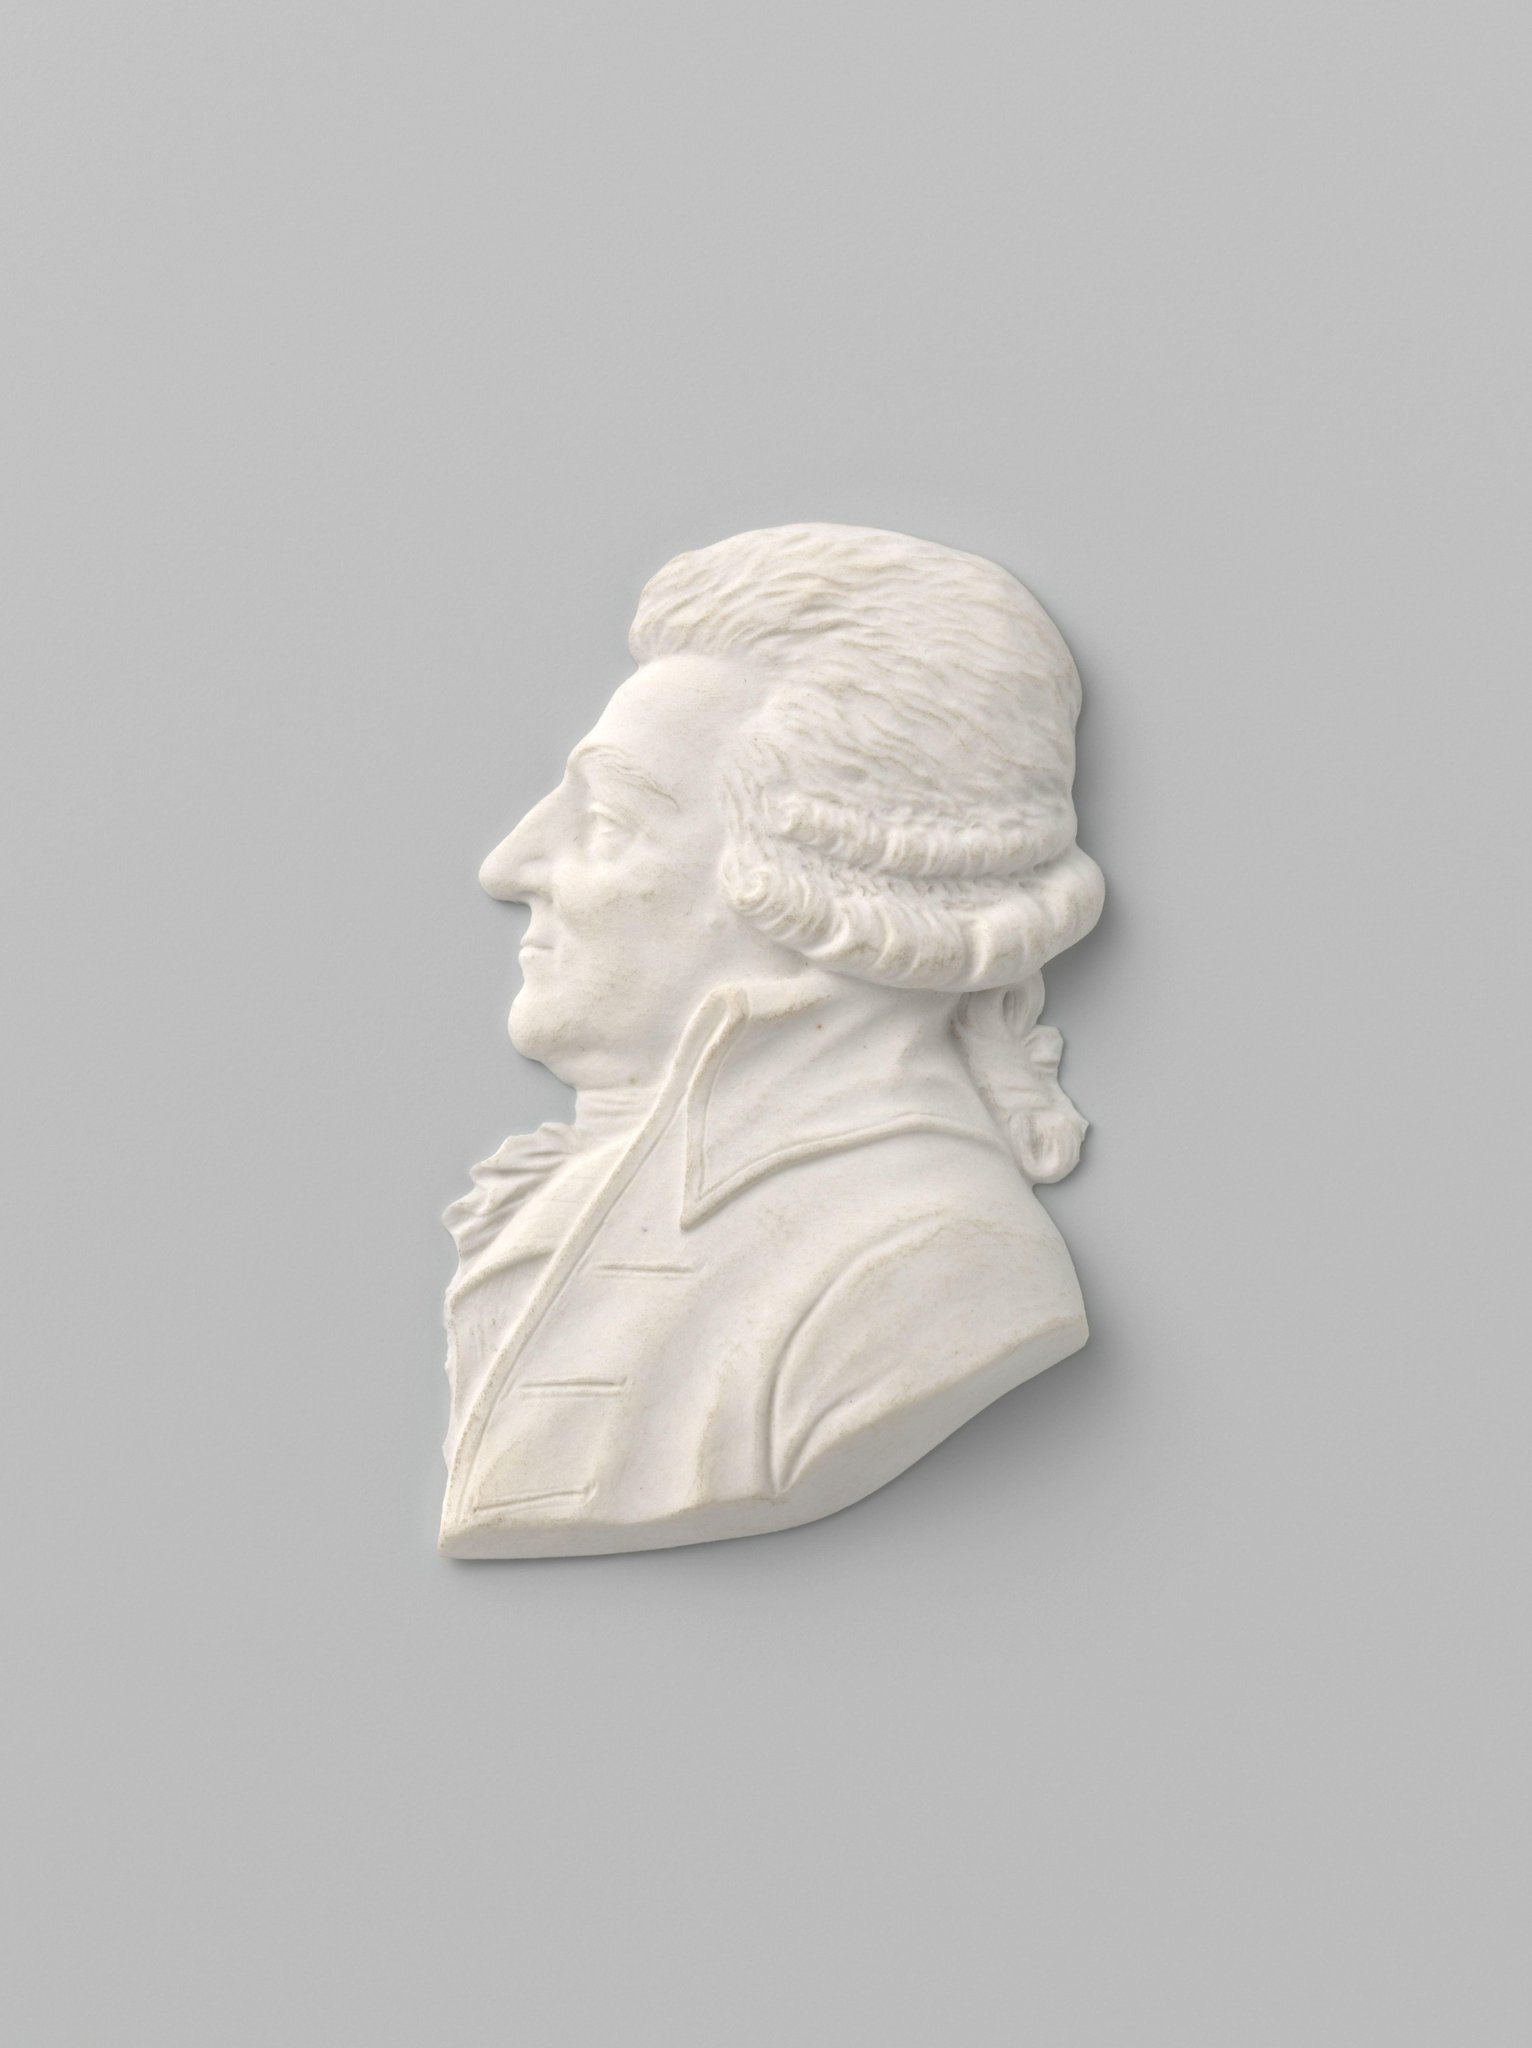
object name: relief sculpture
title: Portrait of the Count of Mirabeau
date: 1780-1795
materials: porcelain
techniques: forming, relief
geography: sèvres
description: Five portraits, from left to right: Benjamin Franklin, the Marquis de La Fayette, the Comte de Mirabeau, Jean-Jacques Rousseau and Marie Antoinette. Biscuit porcelain. Sèvres, c. 1780 - 1795. On loan from the Koninklijk Oudheidkundig Genootschap.